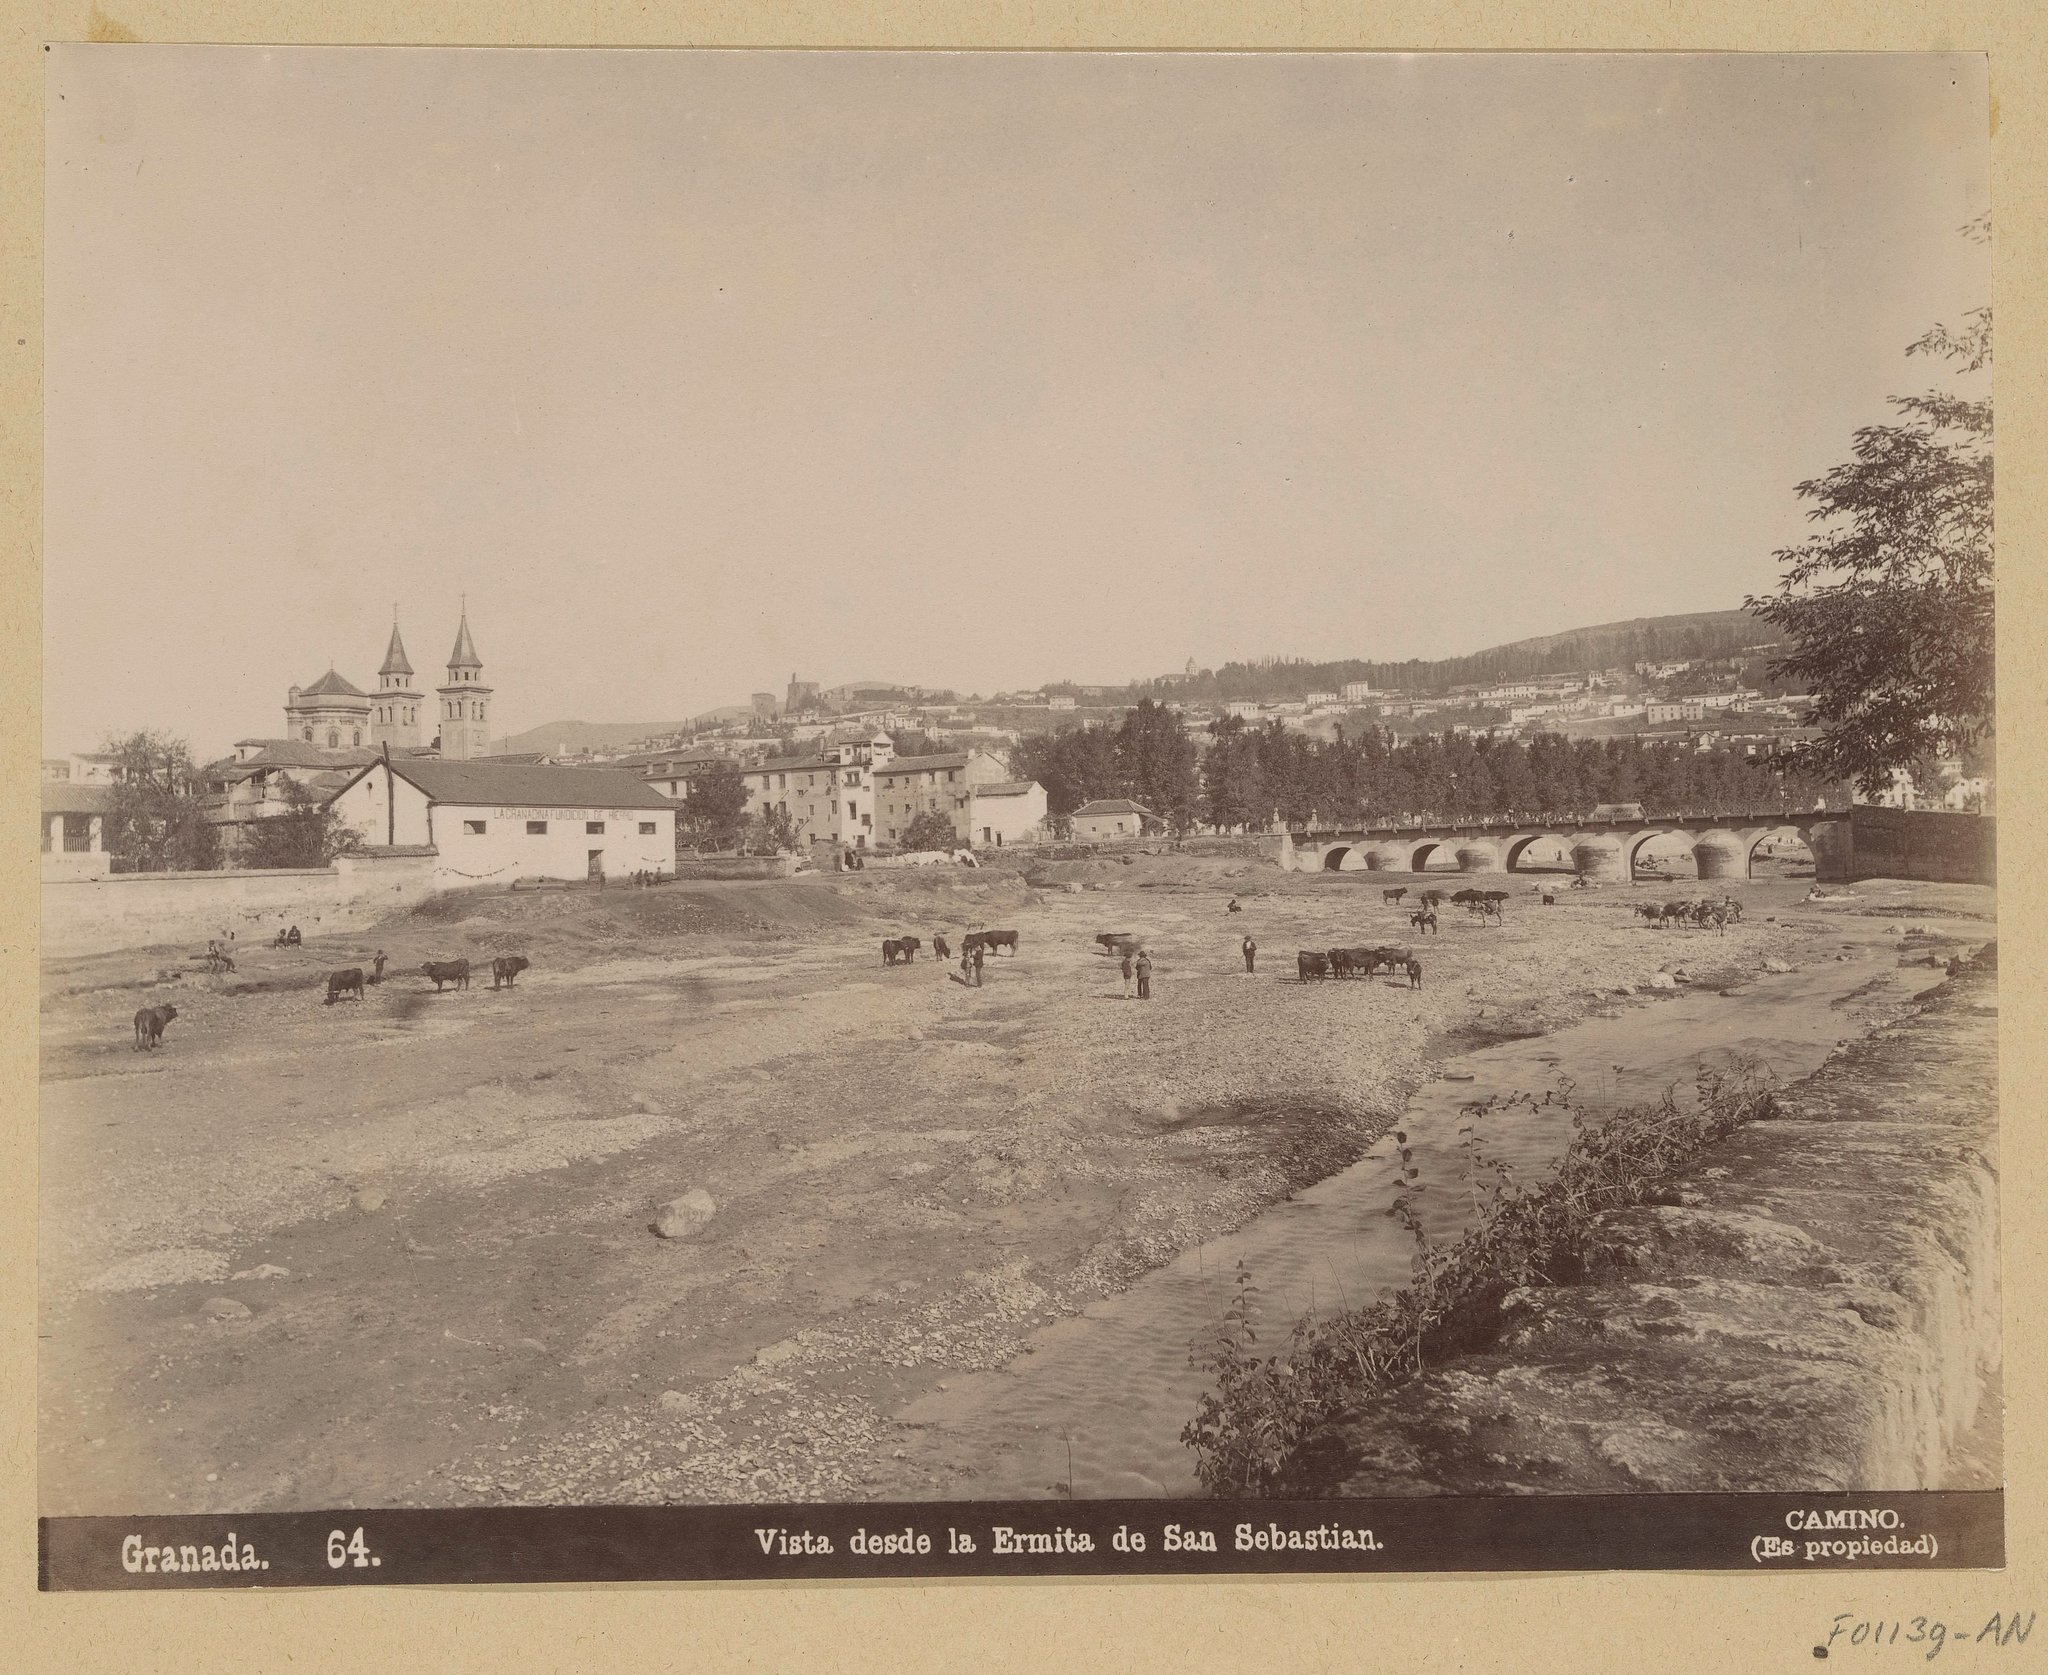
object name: photograph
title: Gezicht op Granada vanaf de Ermita de San Sebastián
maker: camino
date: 1851-1890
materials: paper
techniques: albumen print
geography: granada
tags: city-view in general; 'veduta', hermitage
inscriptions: number: ‘64.’, inscription: ‘(Es propiedad)’